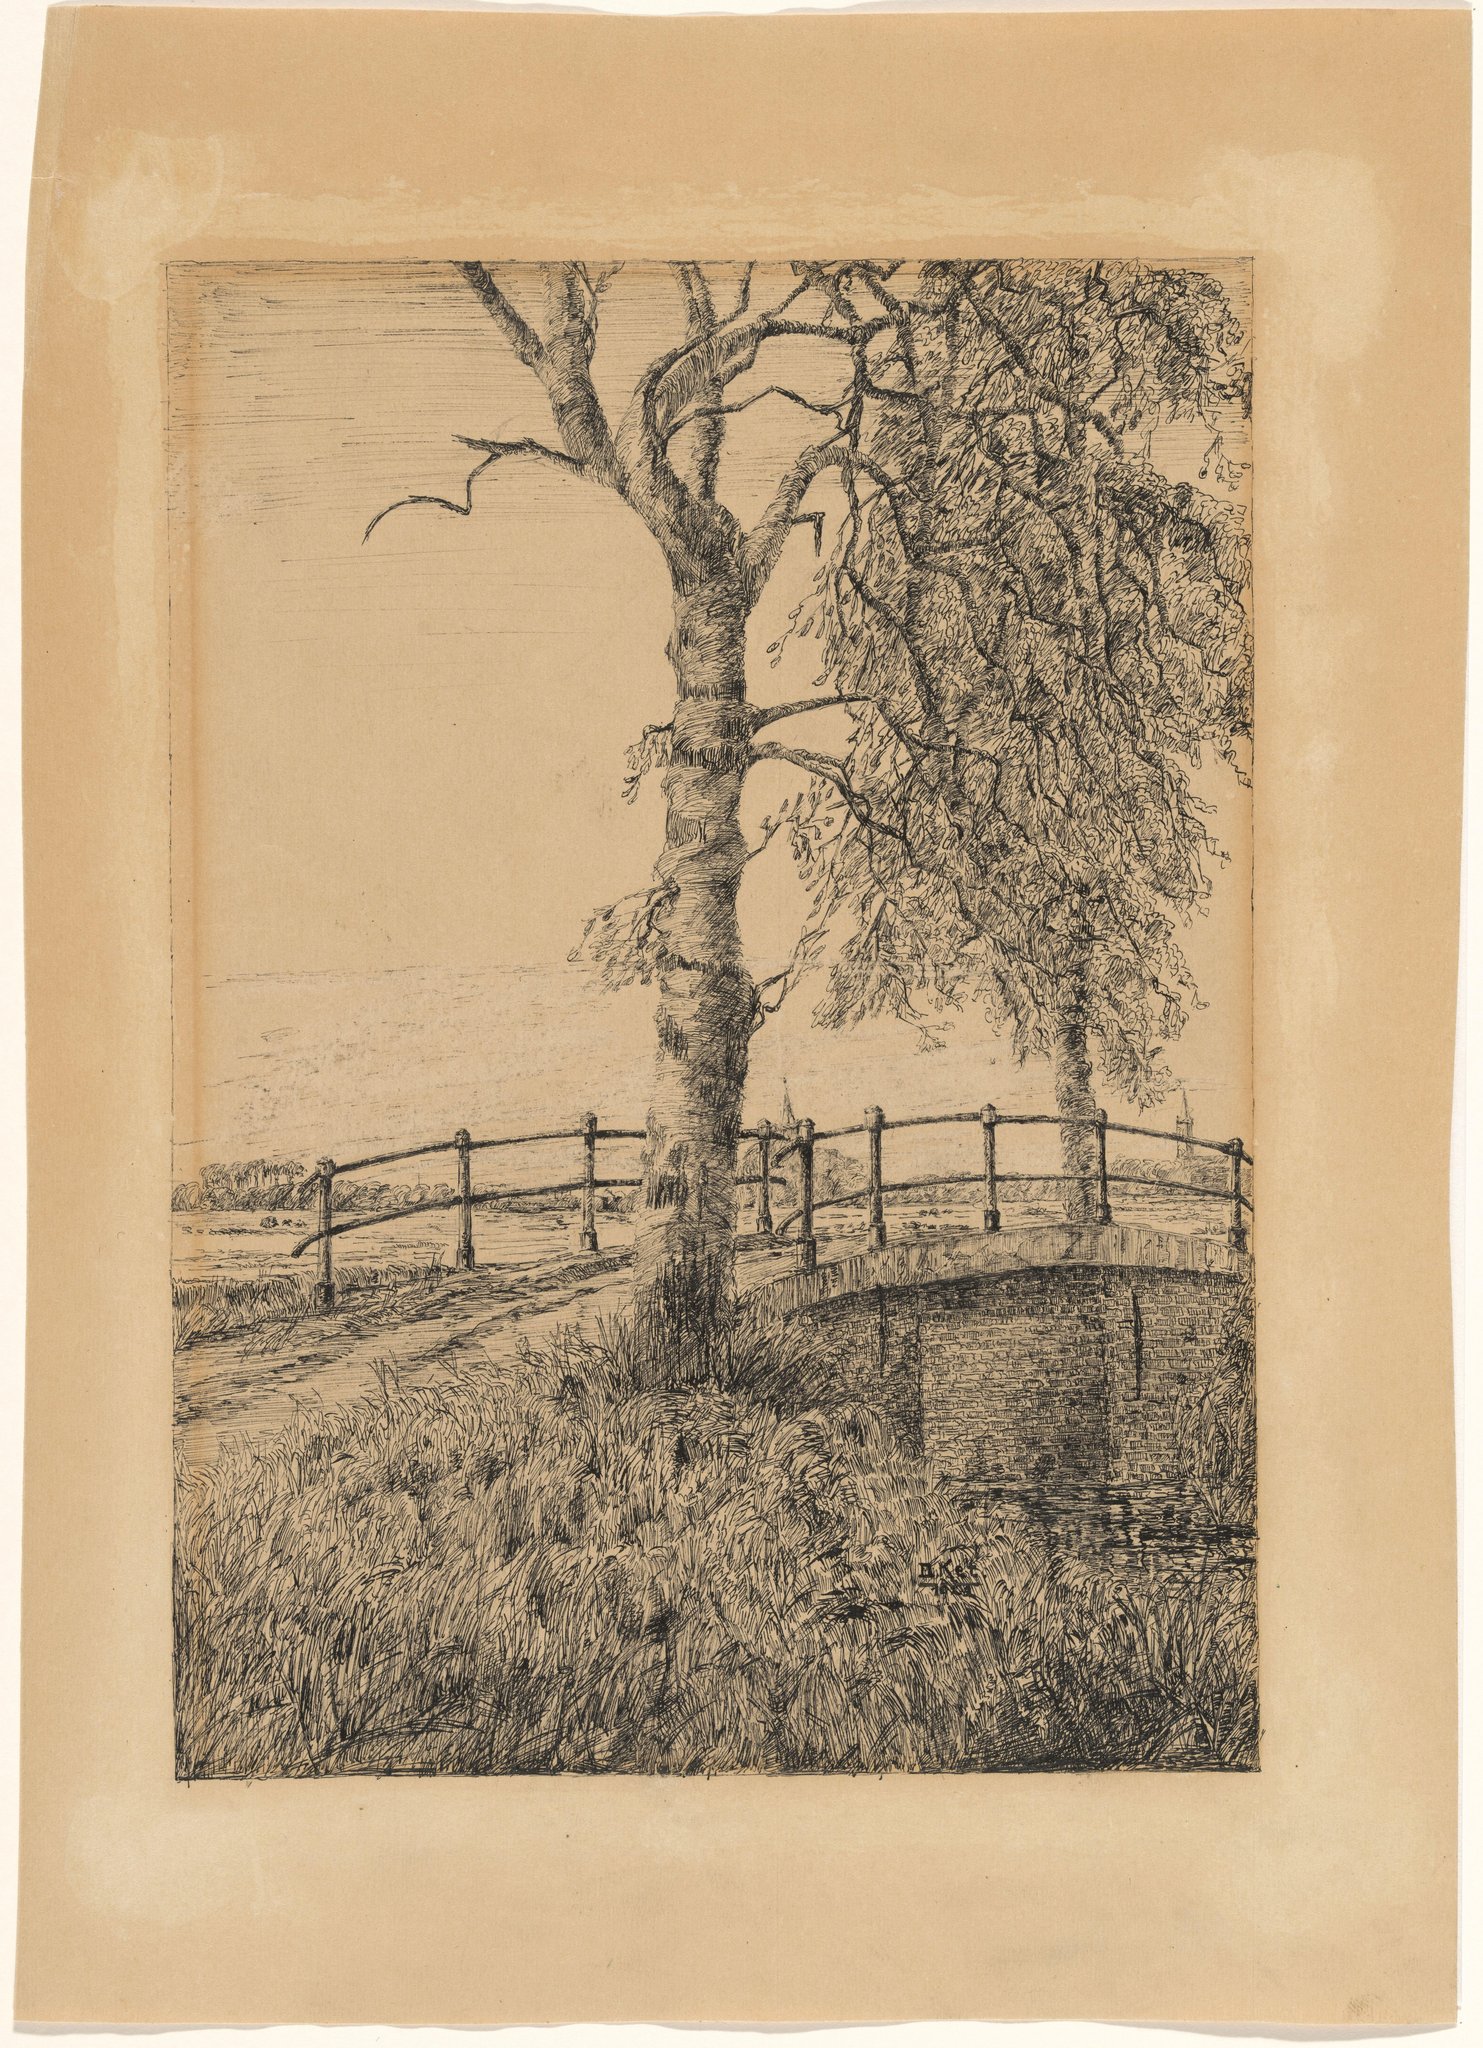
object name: drawing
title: Boom en brug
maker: dick ket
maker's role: draughtsman, print maker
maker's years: 1902-1940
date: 1922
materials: ink, paper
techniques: pen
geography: hoorn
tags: city-view, and landscape with man-made constructions, trees, bridge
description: Voor een brug over water staat een boom. Aan de overzijde van de brug op de achtergrond staat ook een boom.